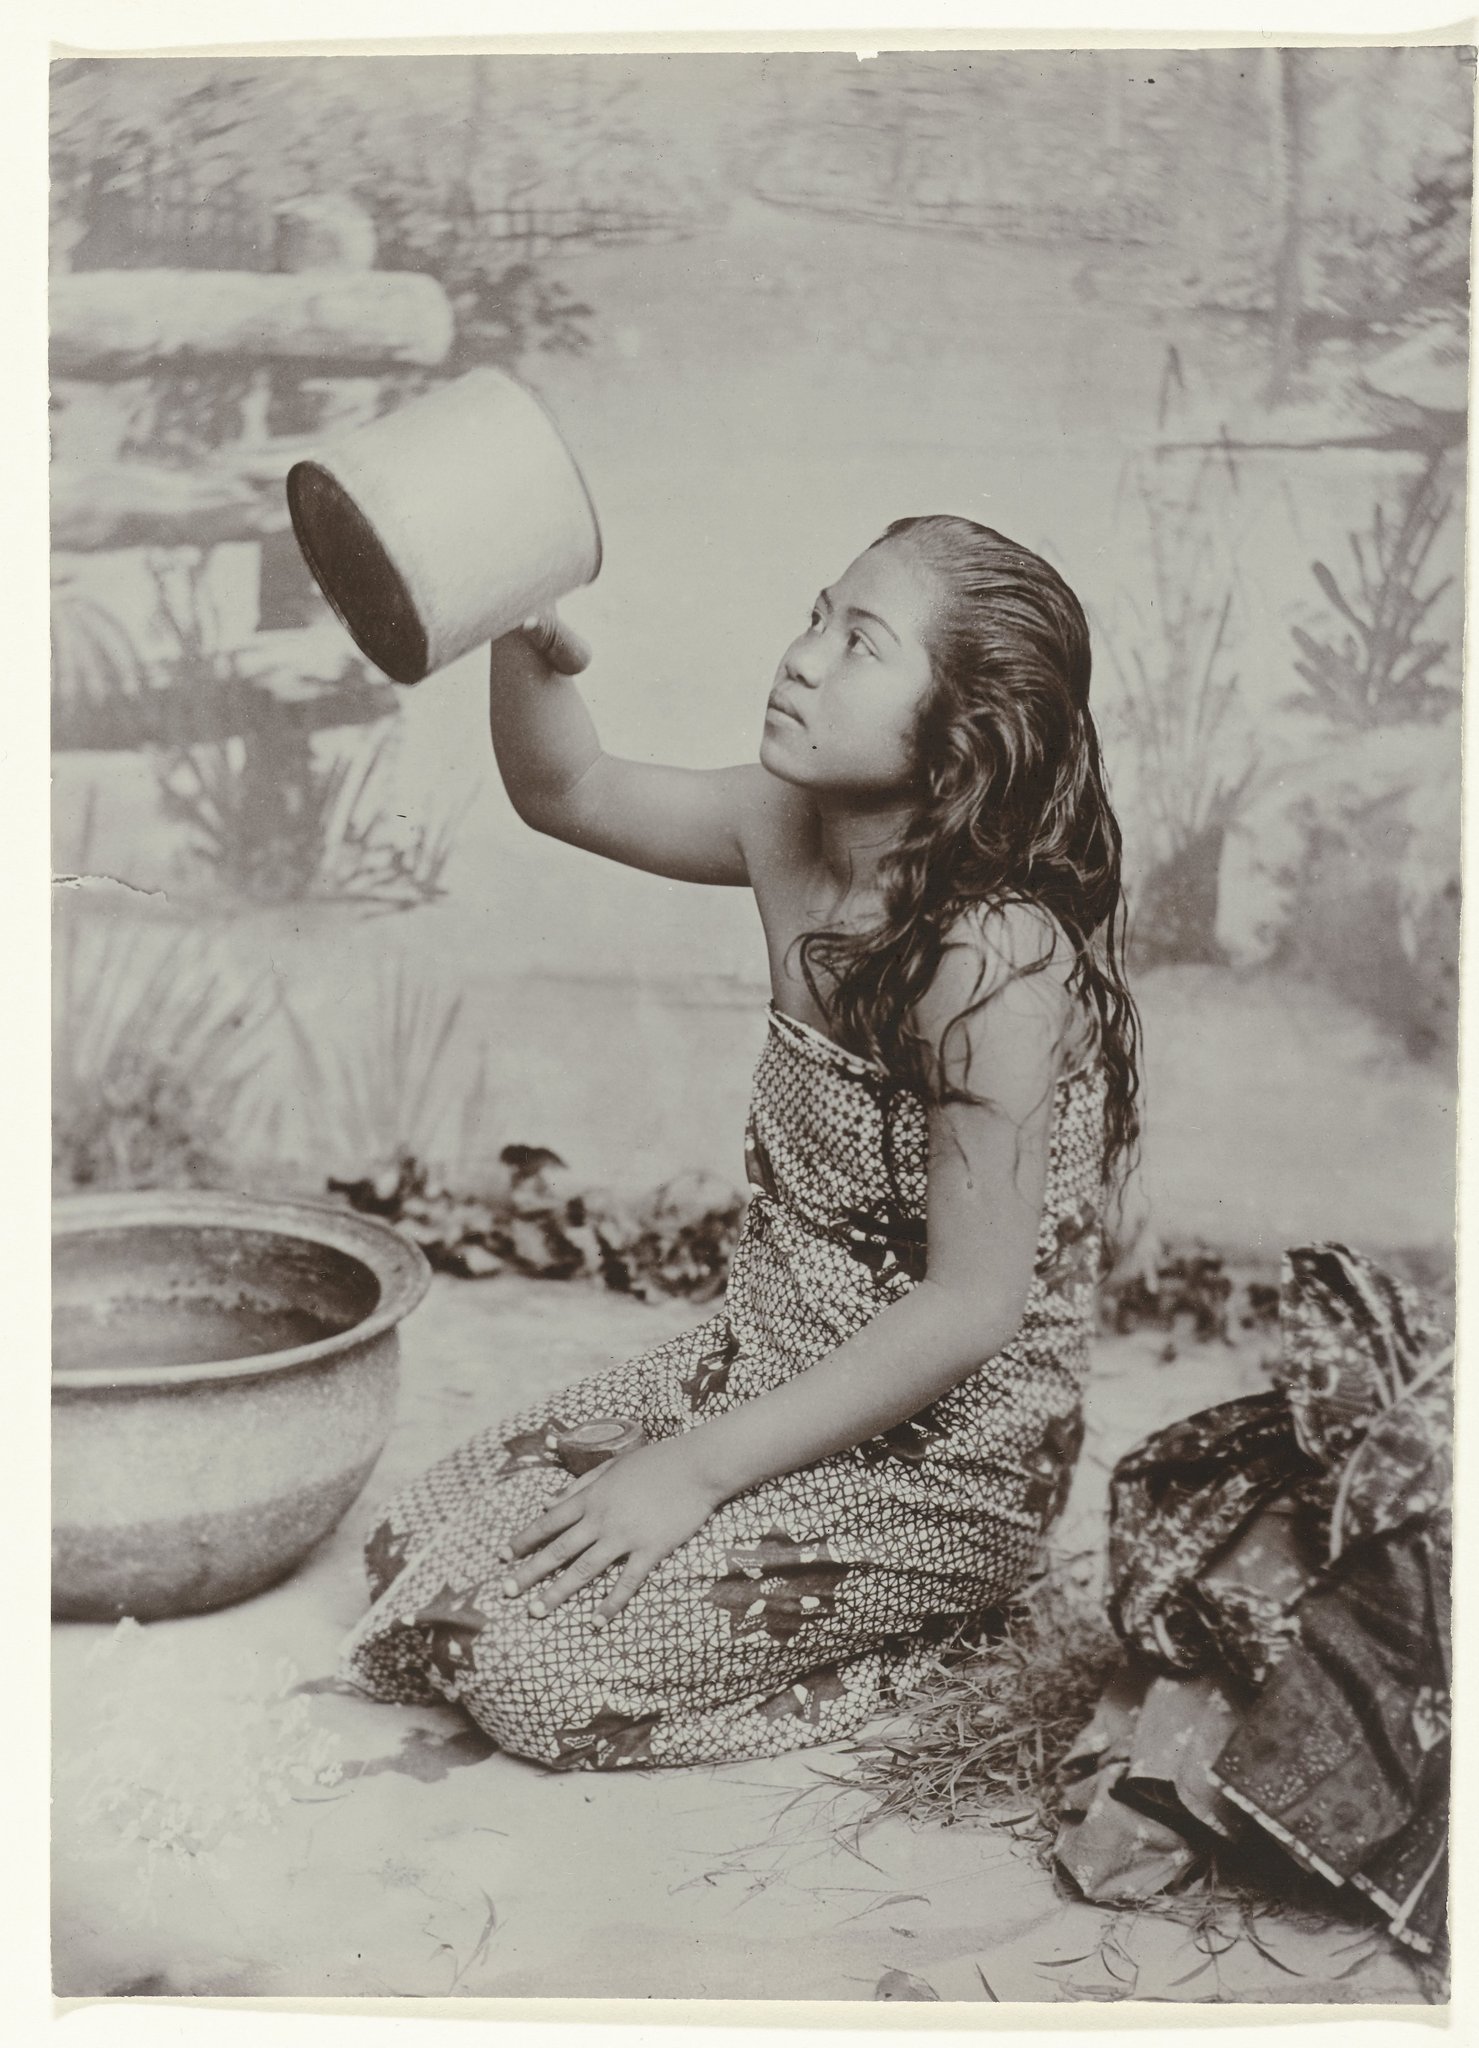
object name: photograph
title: Studioportret van een jonge Javaanse wassende vrouw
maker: kassian céphas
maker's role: fotograaf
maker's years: 1845-1912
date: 1870-1912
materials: cardboard, paper, photographic support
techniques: albumen print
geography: java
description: Studioportret van een jonge Javaanse vrouw die zich wast met een kom met water. De vrouw draagt een batik sarong.